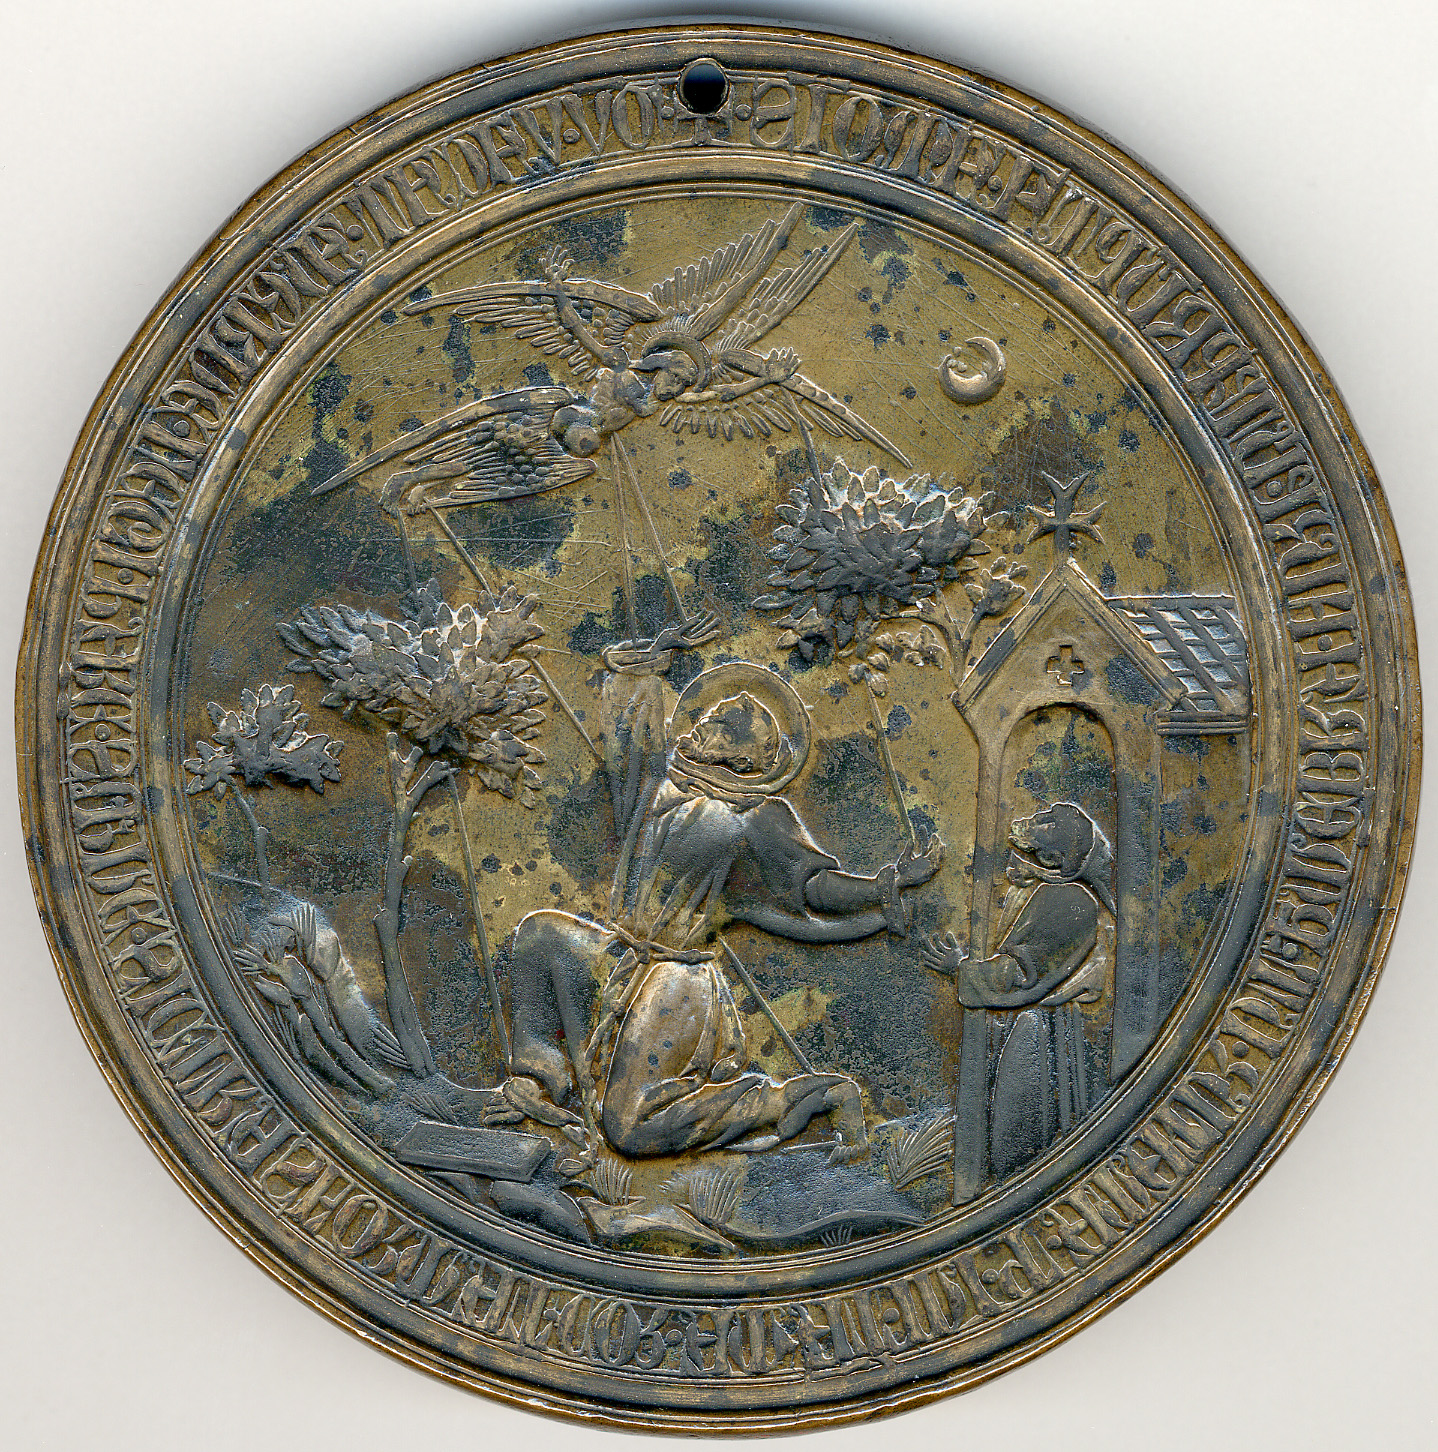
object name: seal matrix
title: Seal Matrix, St.Francis Receiving the Stigmata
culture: italian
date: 1301-1400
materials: copper alloy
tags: angels,saint francis